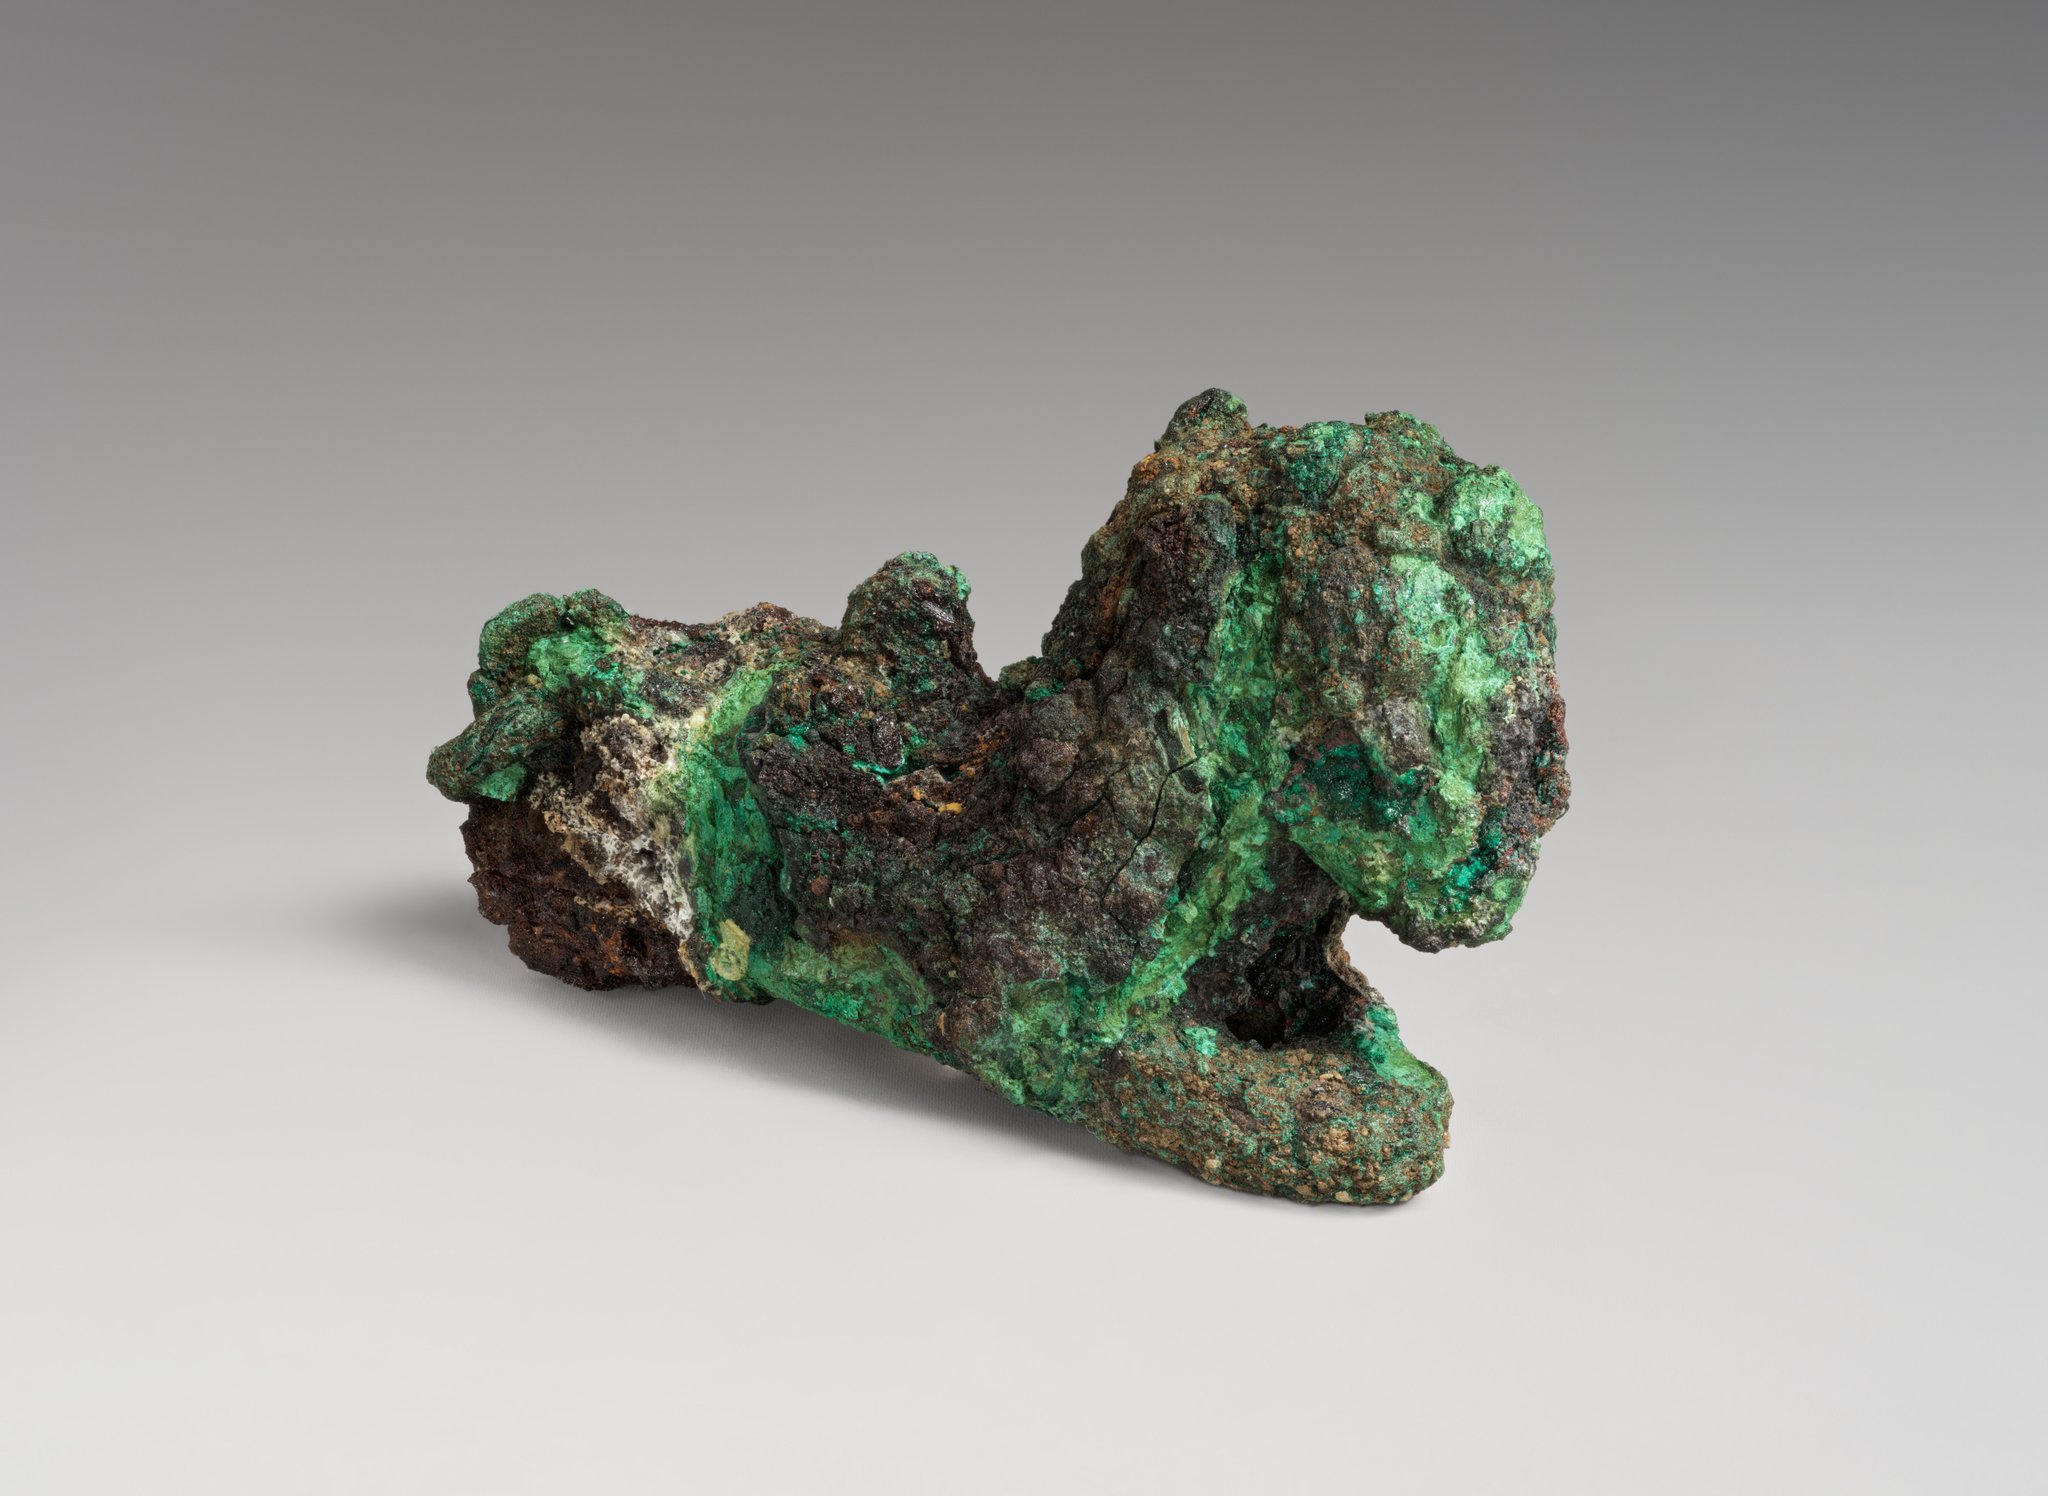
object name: pin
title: Lion pin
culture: iranian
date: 900-801 BCE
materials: bronze, iron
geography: iran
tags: lions